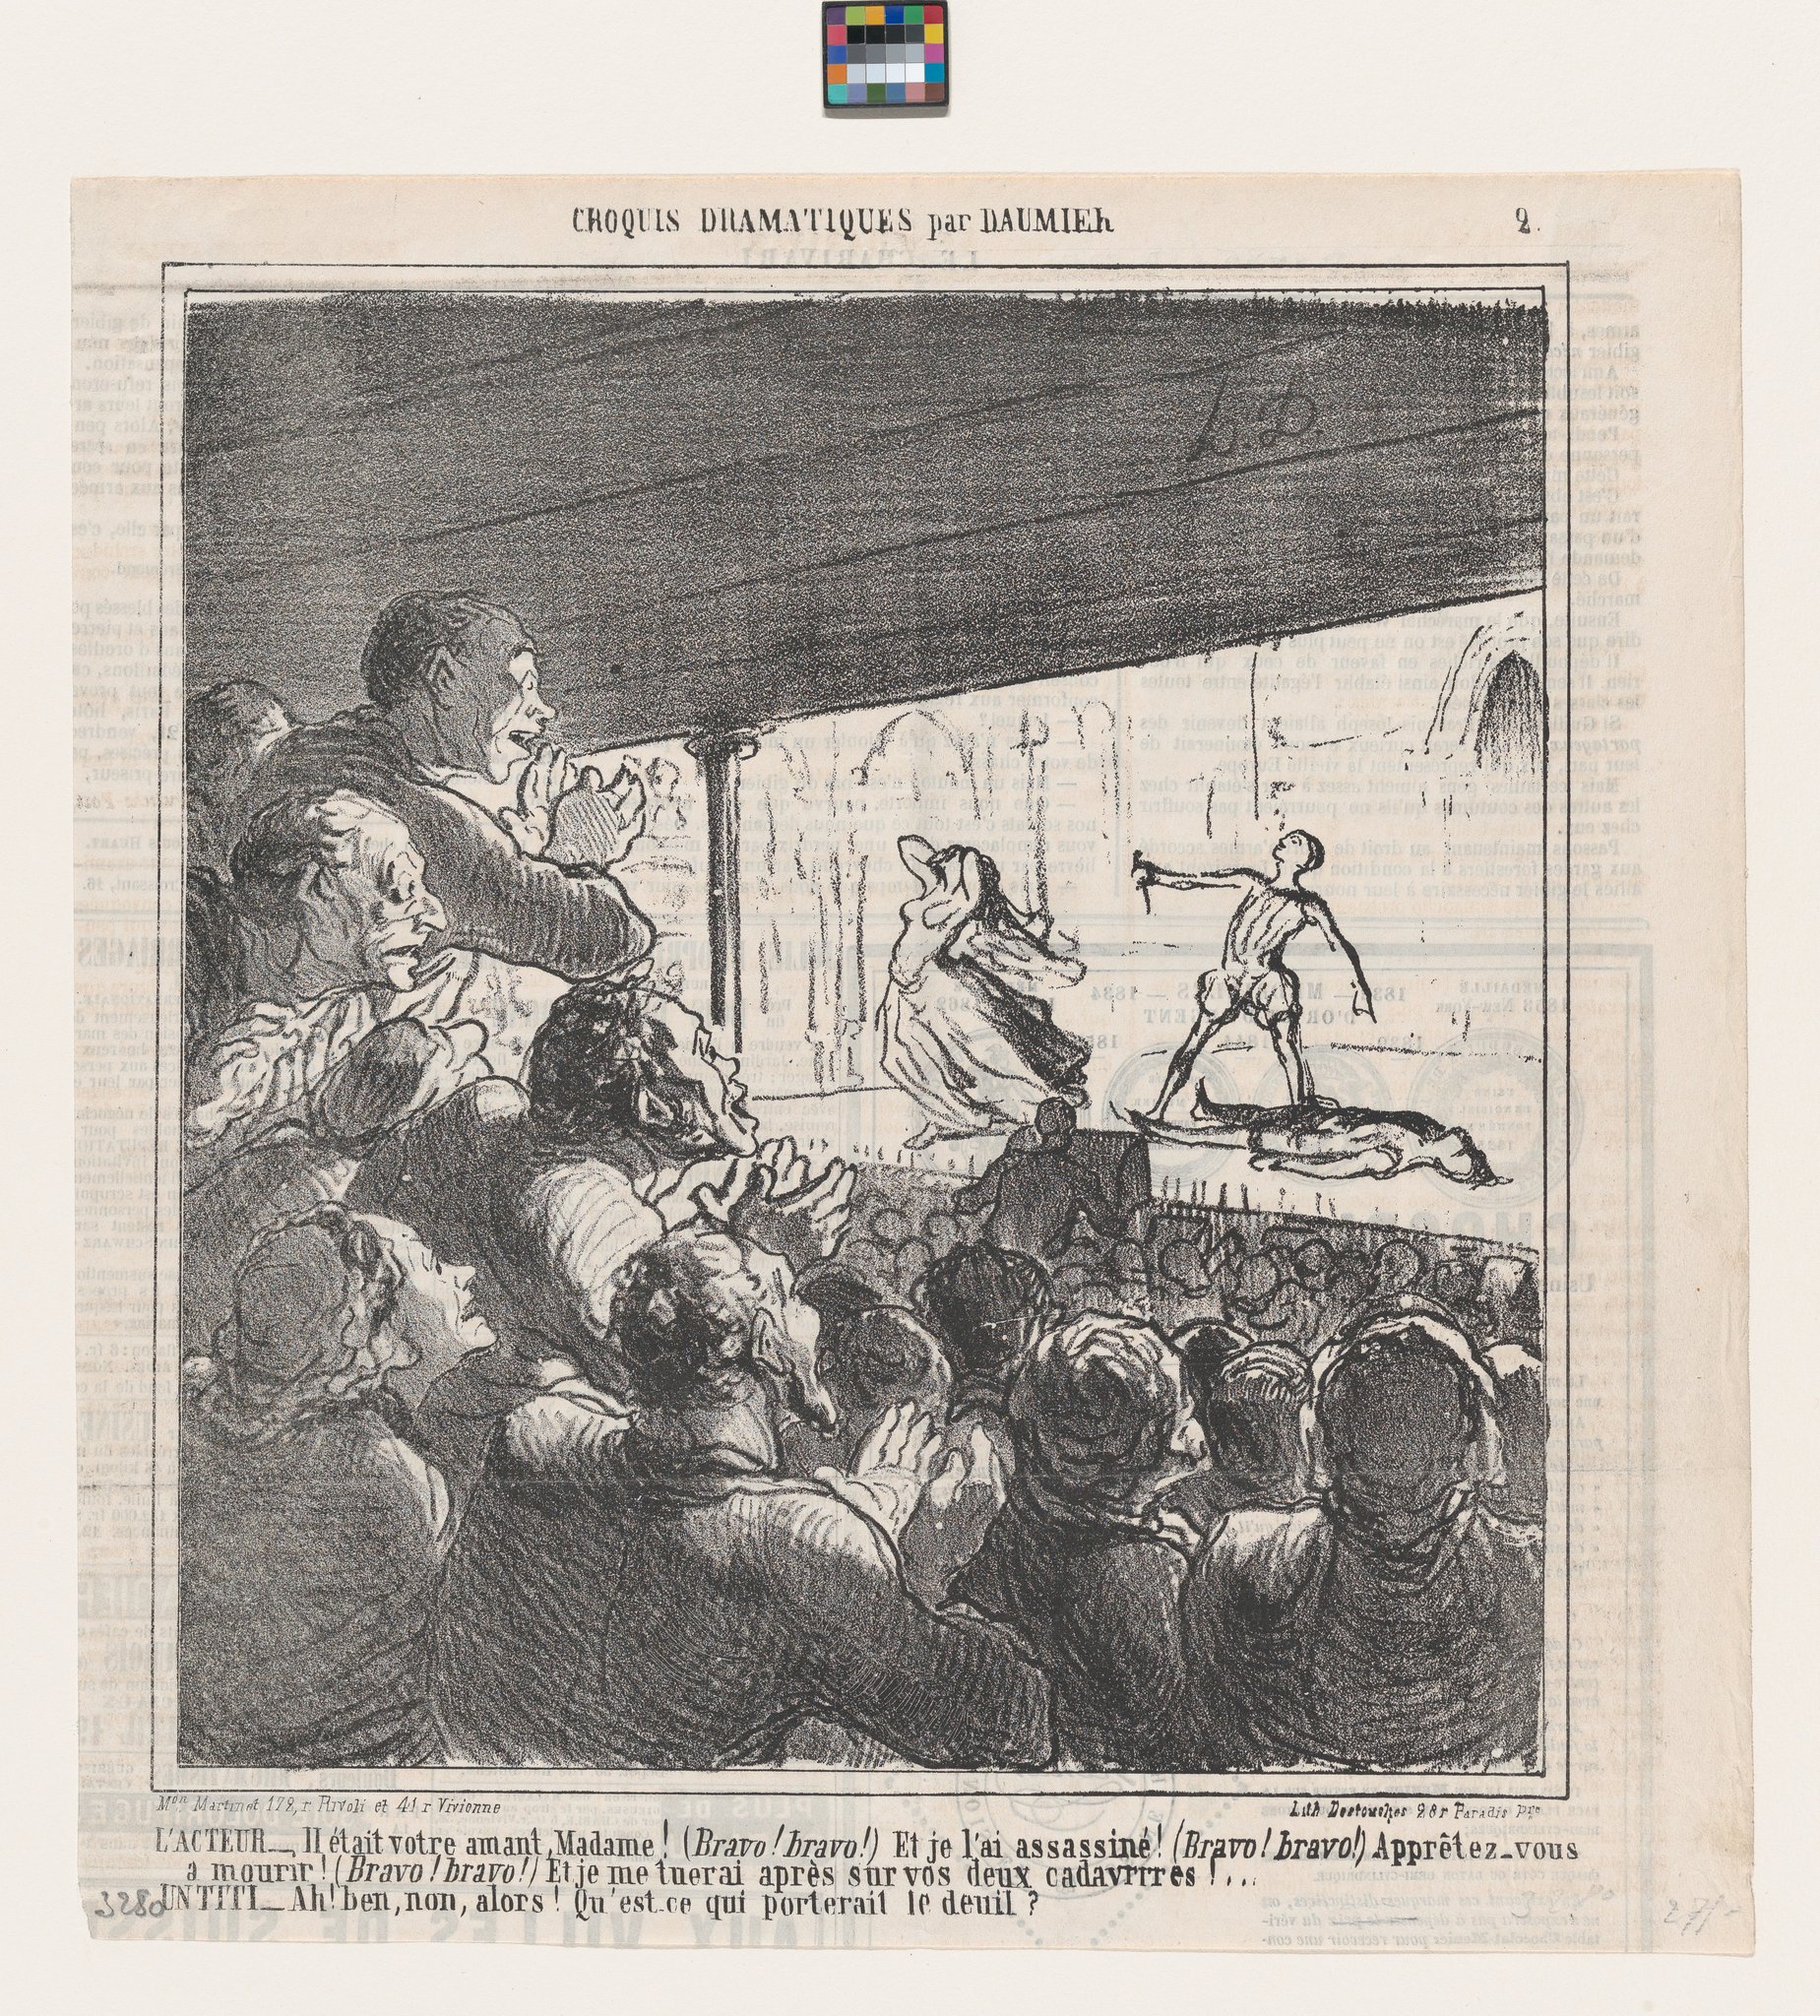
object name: print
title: The actor and a street urchin, from 'Dramatic sketches,' published in Le Charivari, April 18, 1864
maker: honoré daumier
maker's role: artist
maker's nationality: french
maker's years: 1808-1879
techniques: lithograph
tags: satire,theatre,spectators,actors